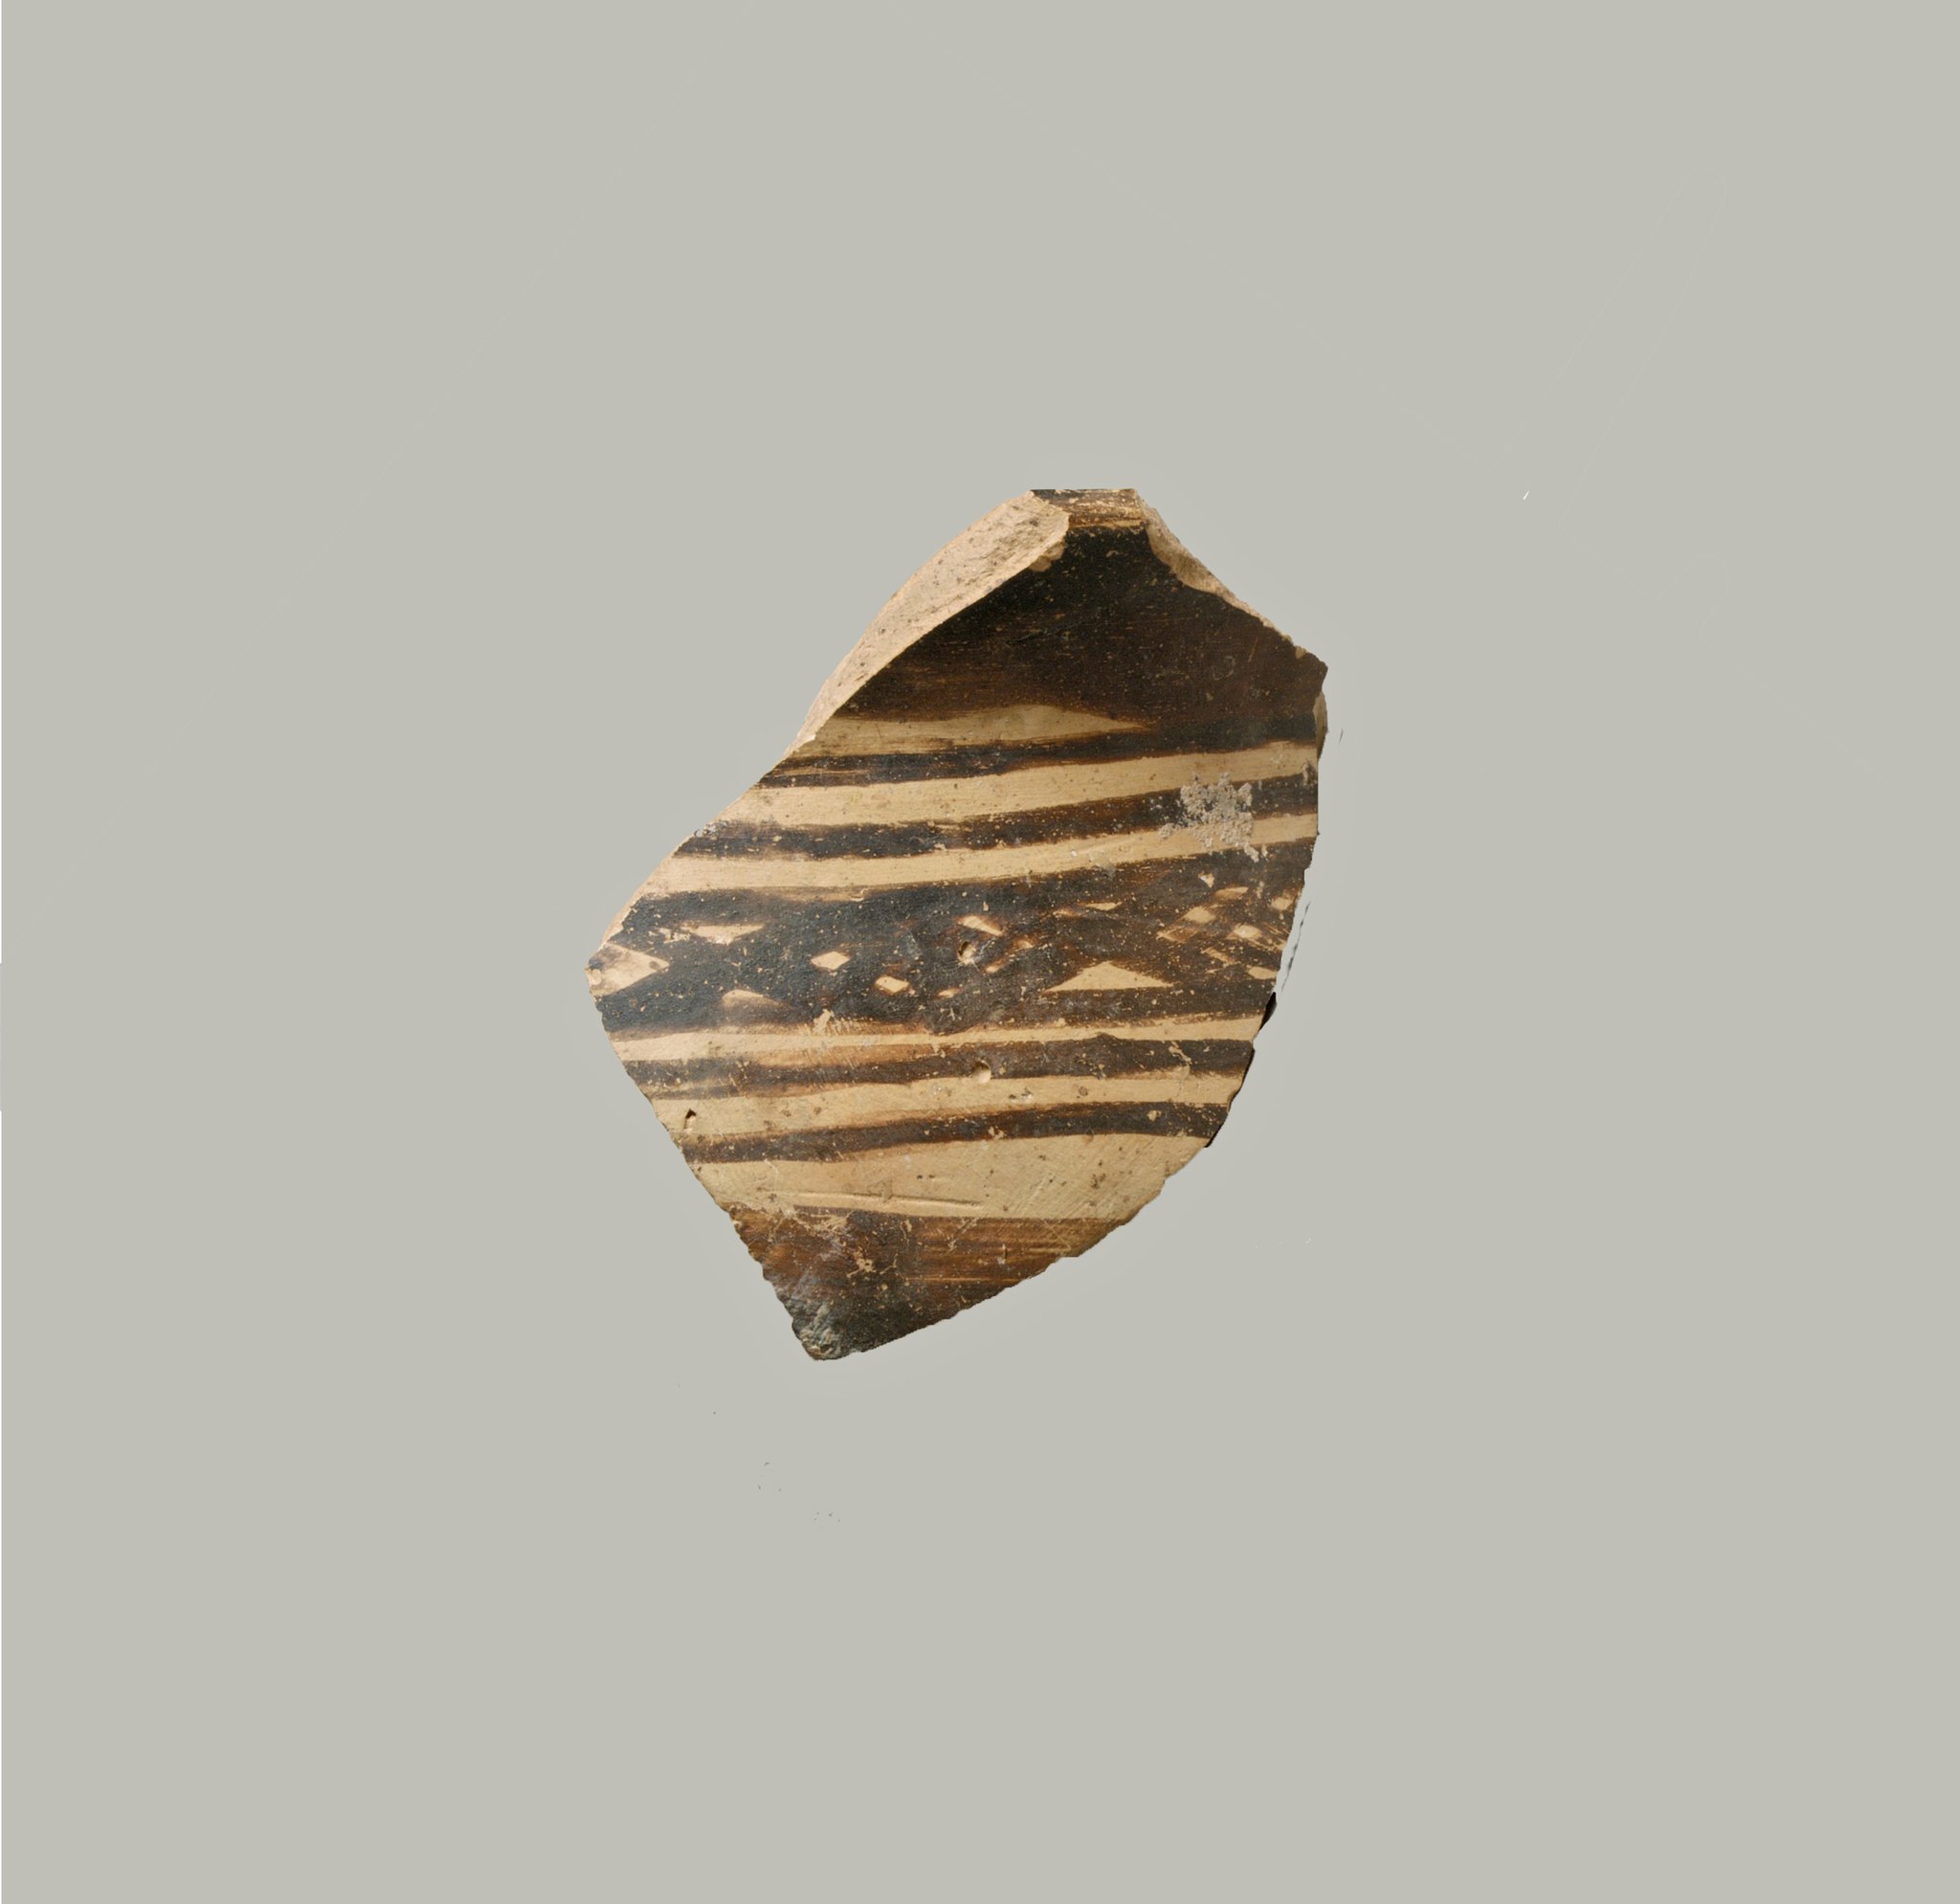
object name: vase fragment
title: Terracotta rim fragment with horizontal bands and cross-hatching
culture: helladic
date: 2600-2300 BCE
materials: terracotta